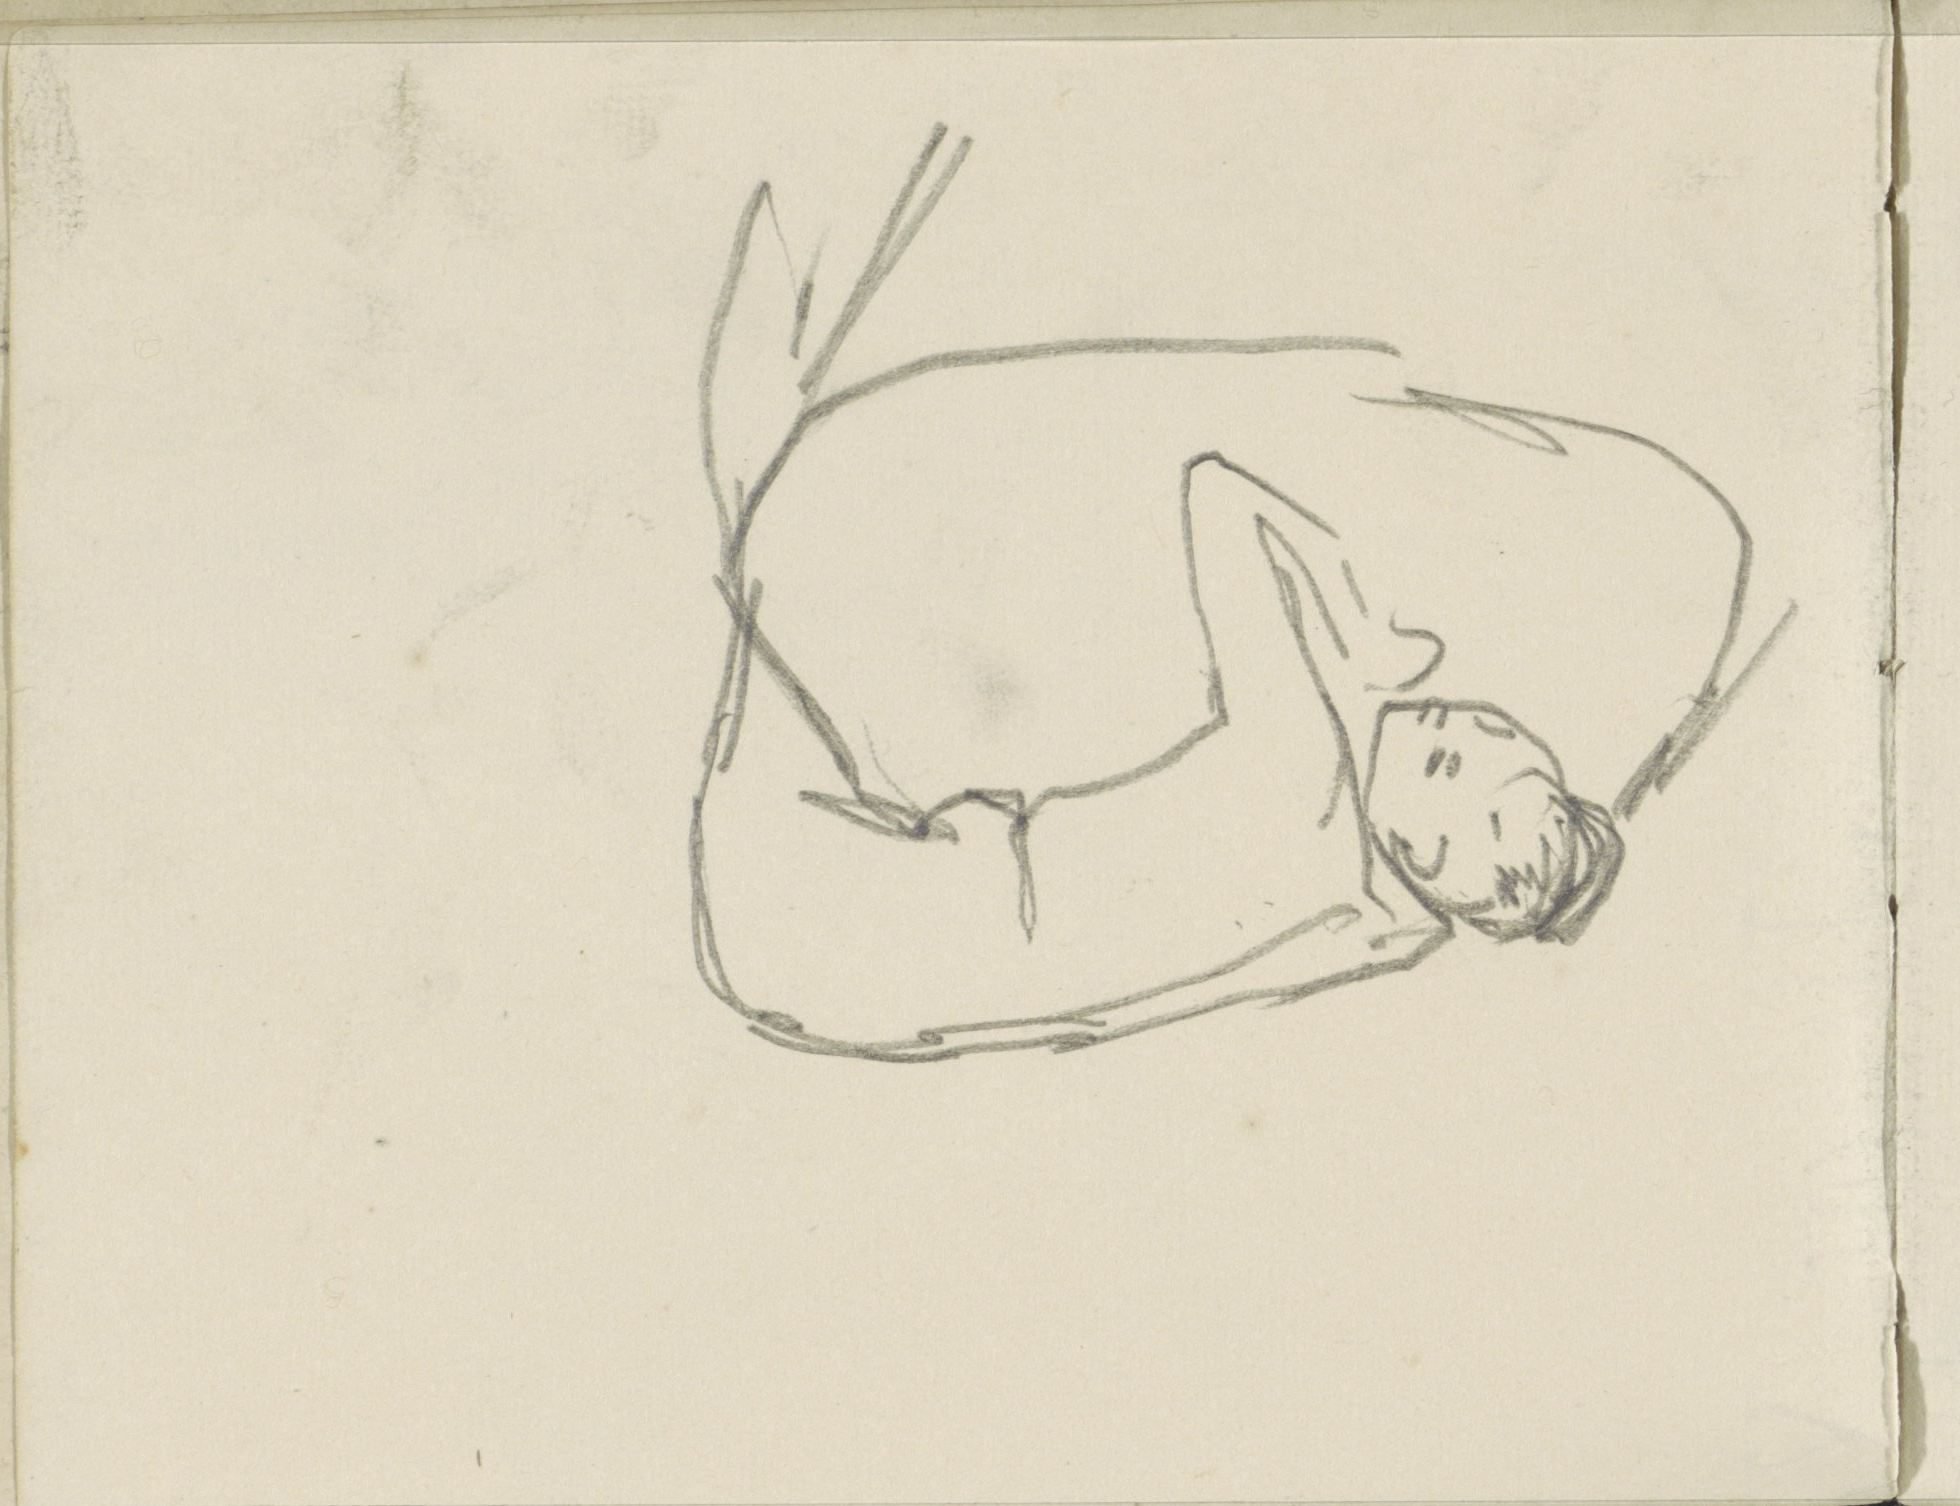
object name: sketchbook leaf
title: Figuurstudie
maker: george hendrik breitner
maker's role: draughtsman, painter, print maker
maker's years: 1857-1923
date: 1886-1903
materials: paper, pencil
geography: amsterdam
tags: adult woman, adult man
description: Pagina 51 uit een schetsboek met 32 bladen.